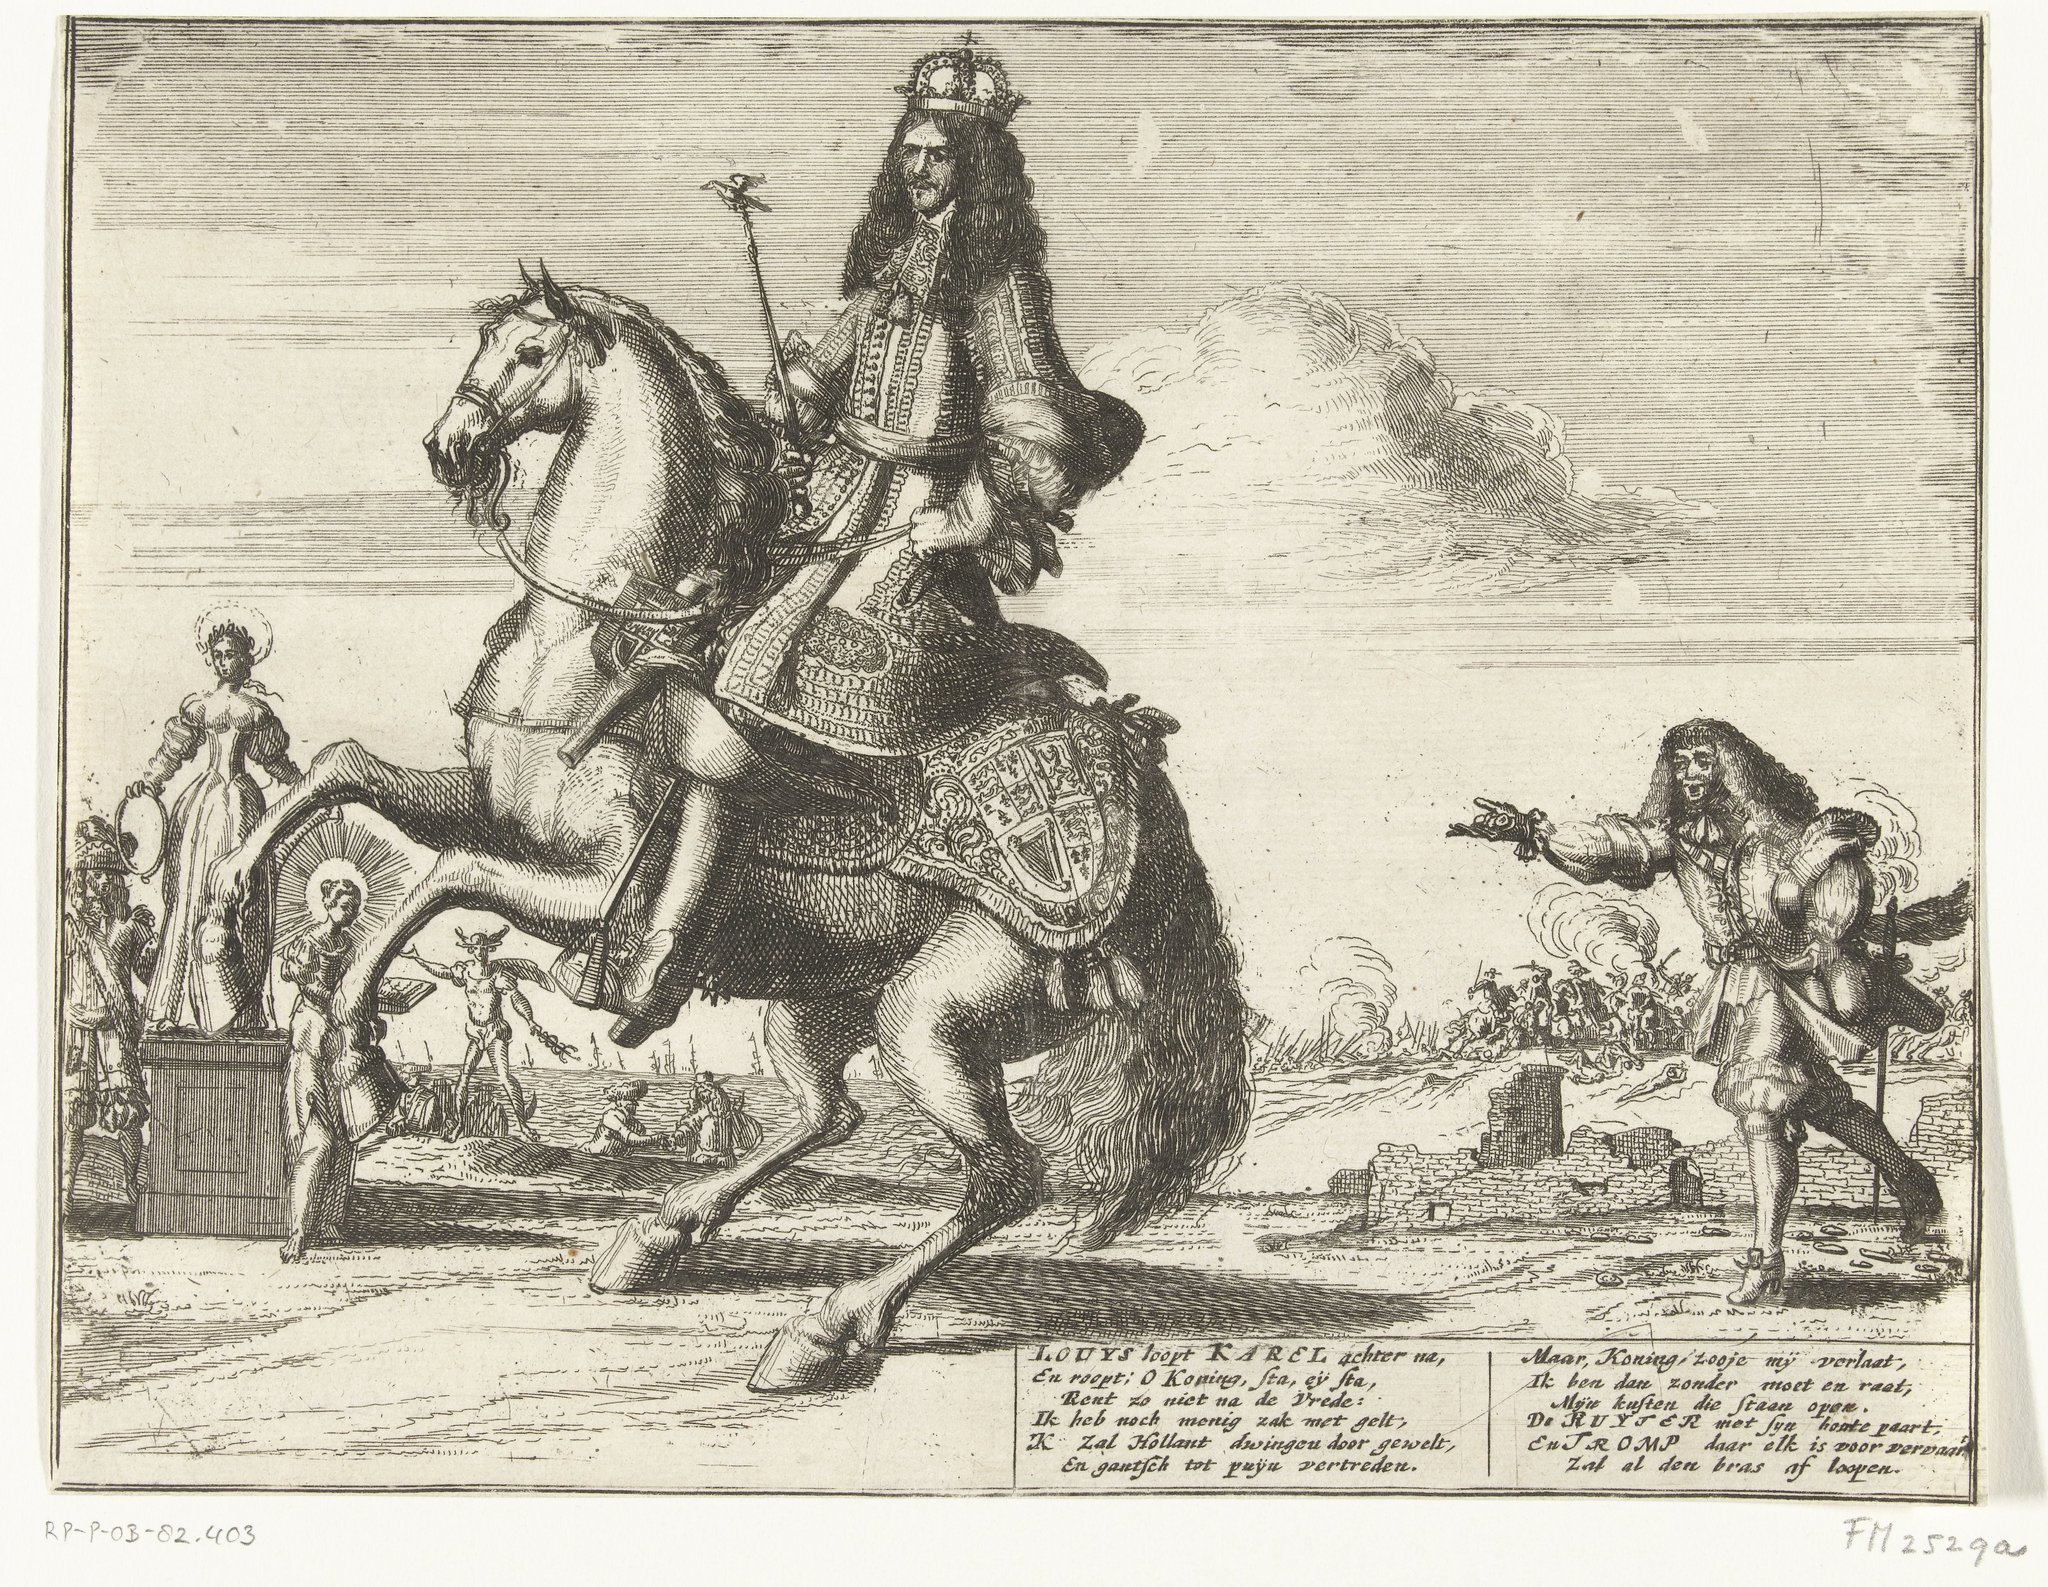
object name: cartoon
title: Spotprent op de pogingen van Frankrijk om de vredeshandel van Engeland met de Republiek te verhinderen, 1674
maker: Anonymous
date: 1674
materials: paper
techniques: etching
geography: northern netherlands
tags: lodewijk xiv (koning van frankrijk), london, karel ii (koning van engeland), political caricatures and satires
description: Spotprent op de pogingen van Frankrijk om de vredeshandel van Engeland met de Republiek te verhinderen, 1674. Koning Karel II van Engeland te paard, rechts loopt de Franse koning Lodewijk XIV beladen met geldzakken hem achterna. Links de Vrede op een voetstuk staande tussen een krijgsman en Godsdienst. Met twee verzen van 6 regels in de plaat.